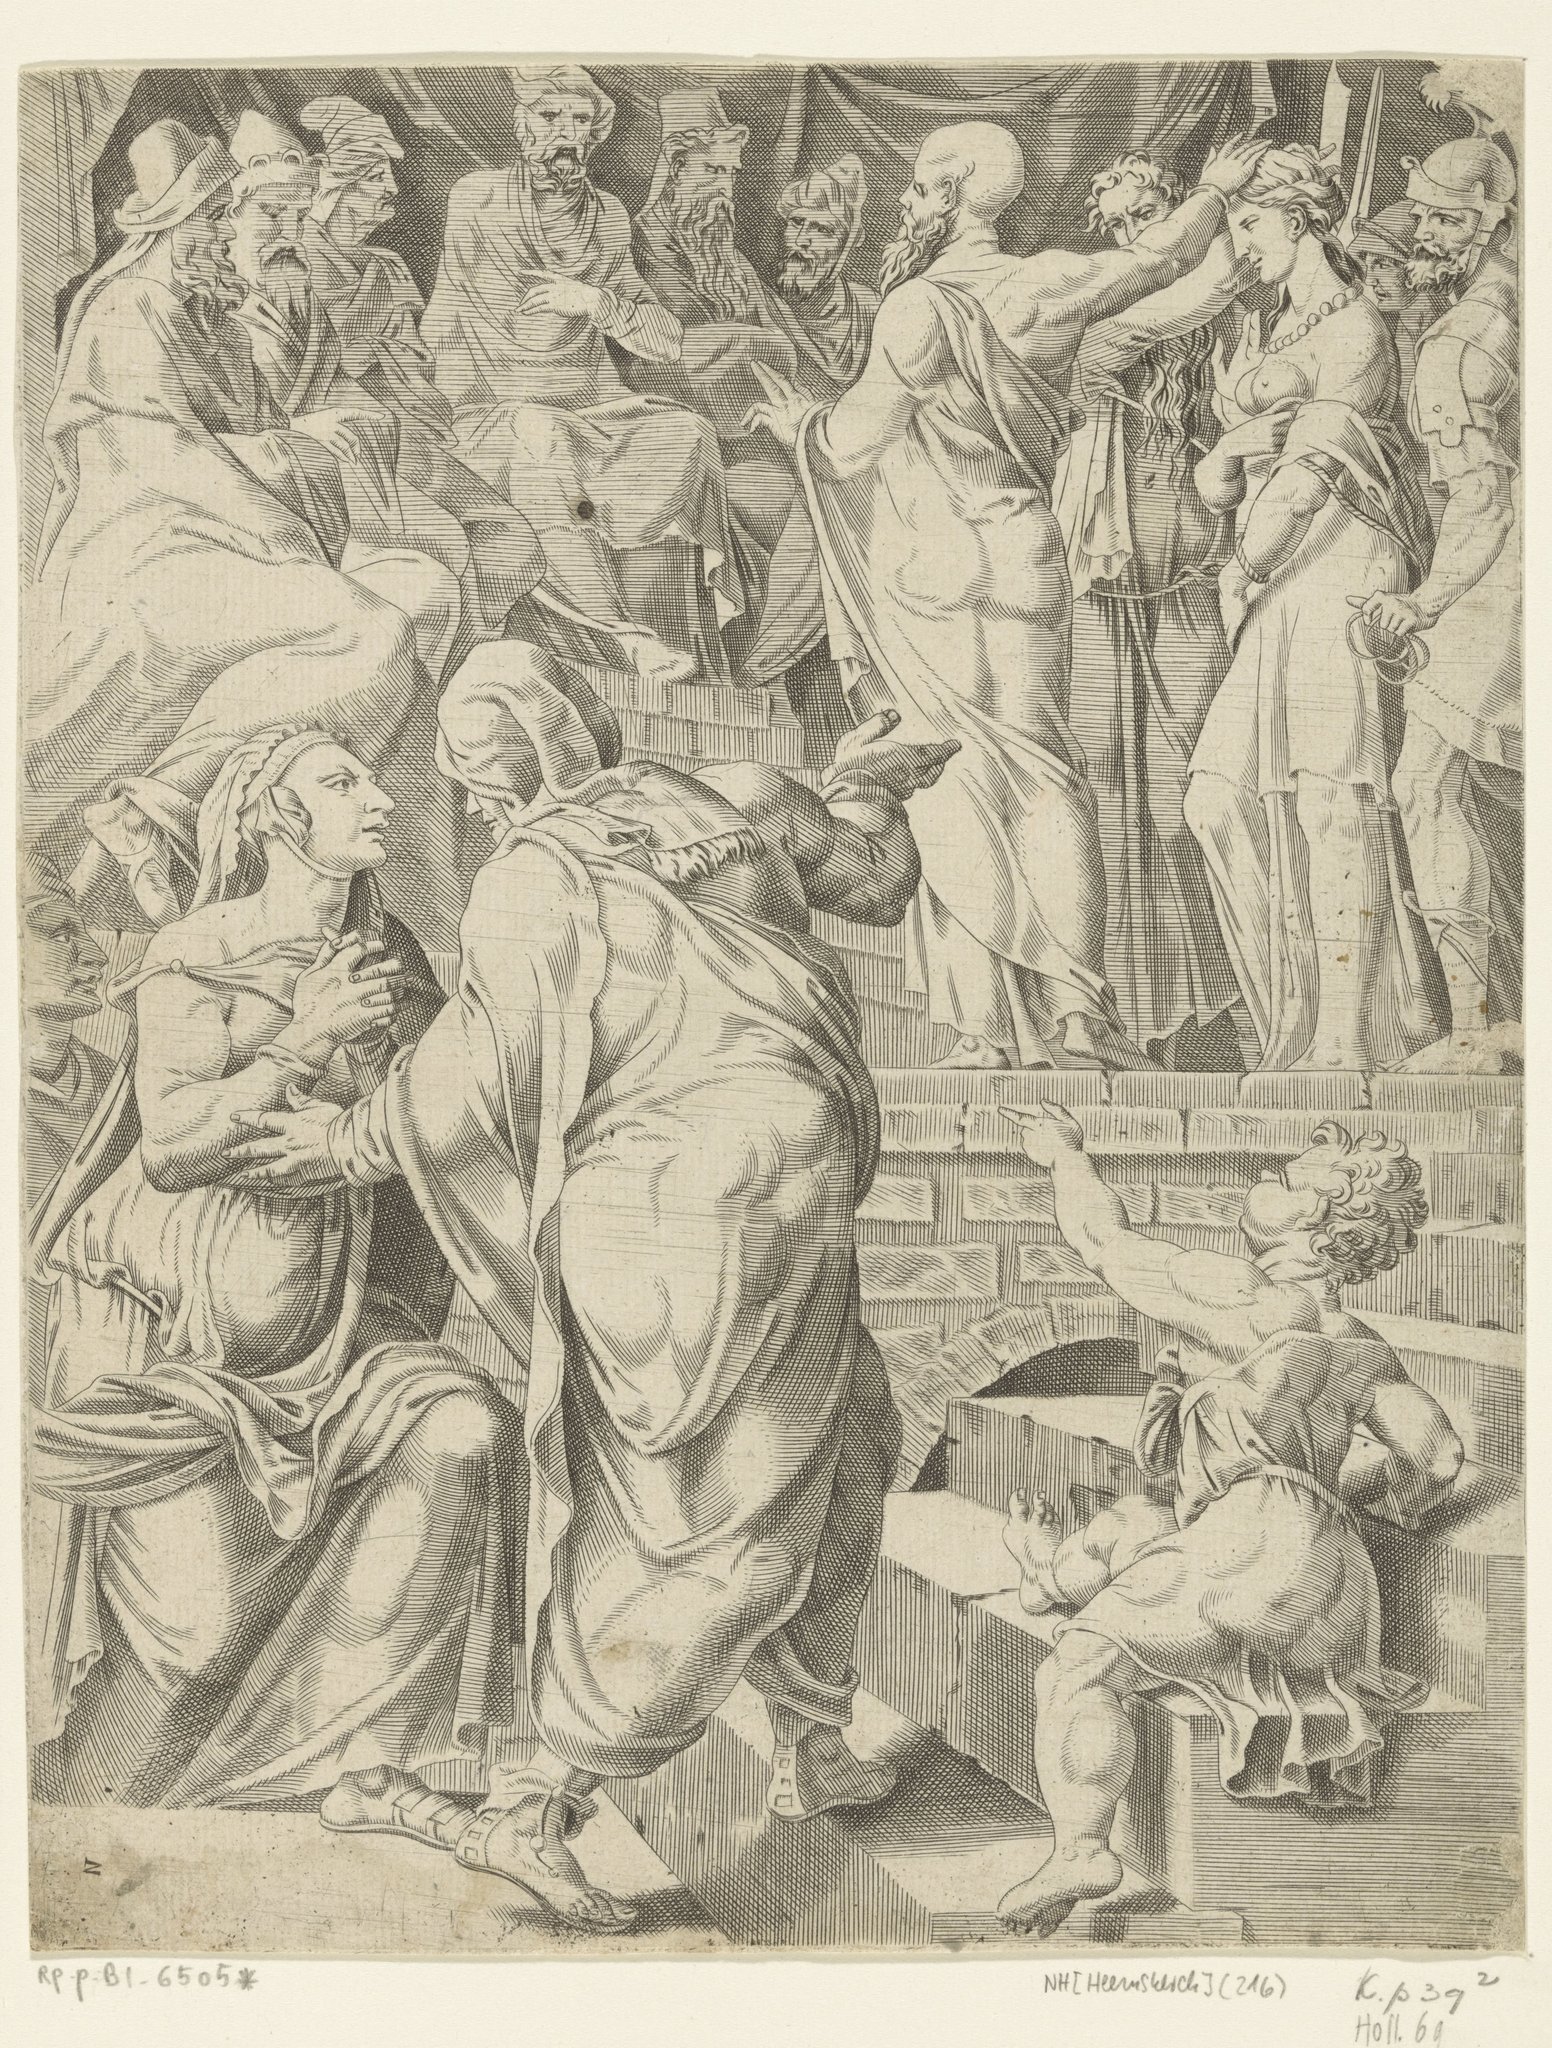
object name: print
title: Christus aan het volk getoond (Ecce Homo)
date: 1602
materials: paper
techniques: engraving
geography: rome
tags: pilate showing christ to the people, 'ostentatio christi', 'ecce homo' (john 19:4-6)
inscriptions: address: ‘Ioannes Orladij [sic] formis romae’, date: ‘1602’, signature: ‘Corn. Co. f:’, address: ‘Antonij Lafrerij Romae’, date: ‘1572’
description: Christus staat geboeid op een bordes van een antiek gebouw, met doornenkroon op het hoofd, omgeven door drie soldaten. Pilatus, rechts, toont Christus aan het volk dat, op de voorgrond op de rug gezien, schreeuwt dat hij gekruisigd moet worden. Een van de mannen houdt een kruis vast.